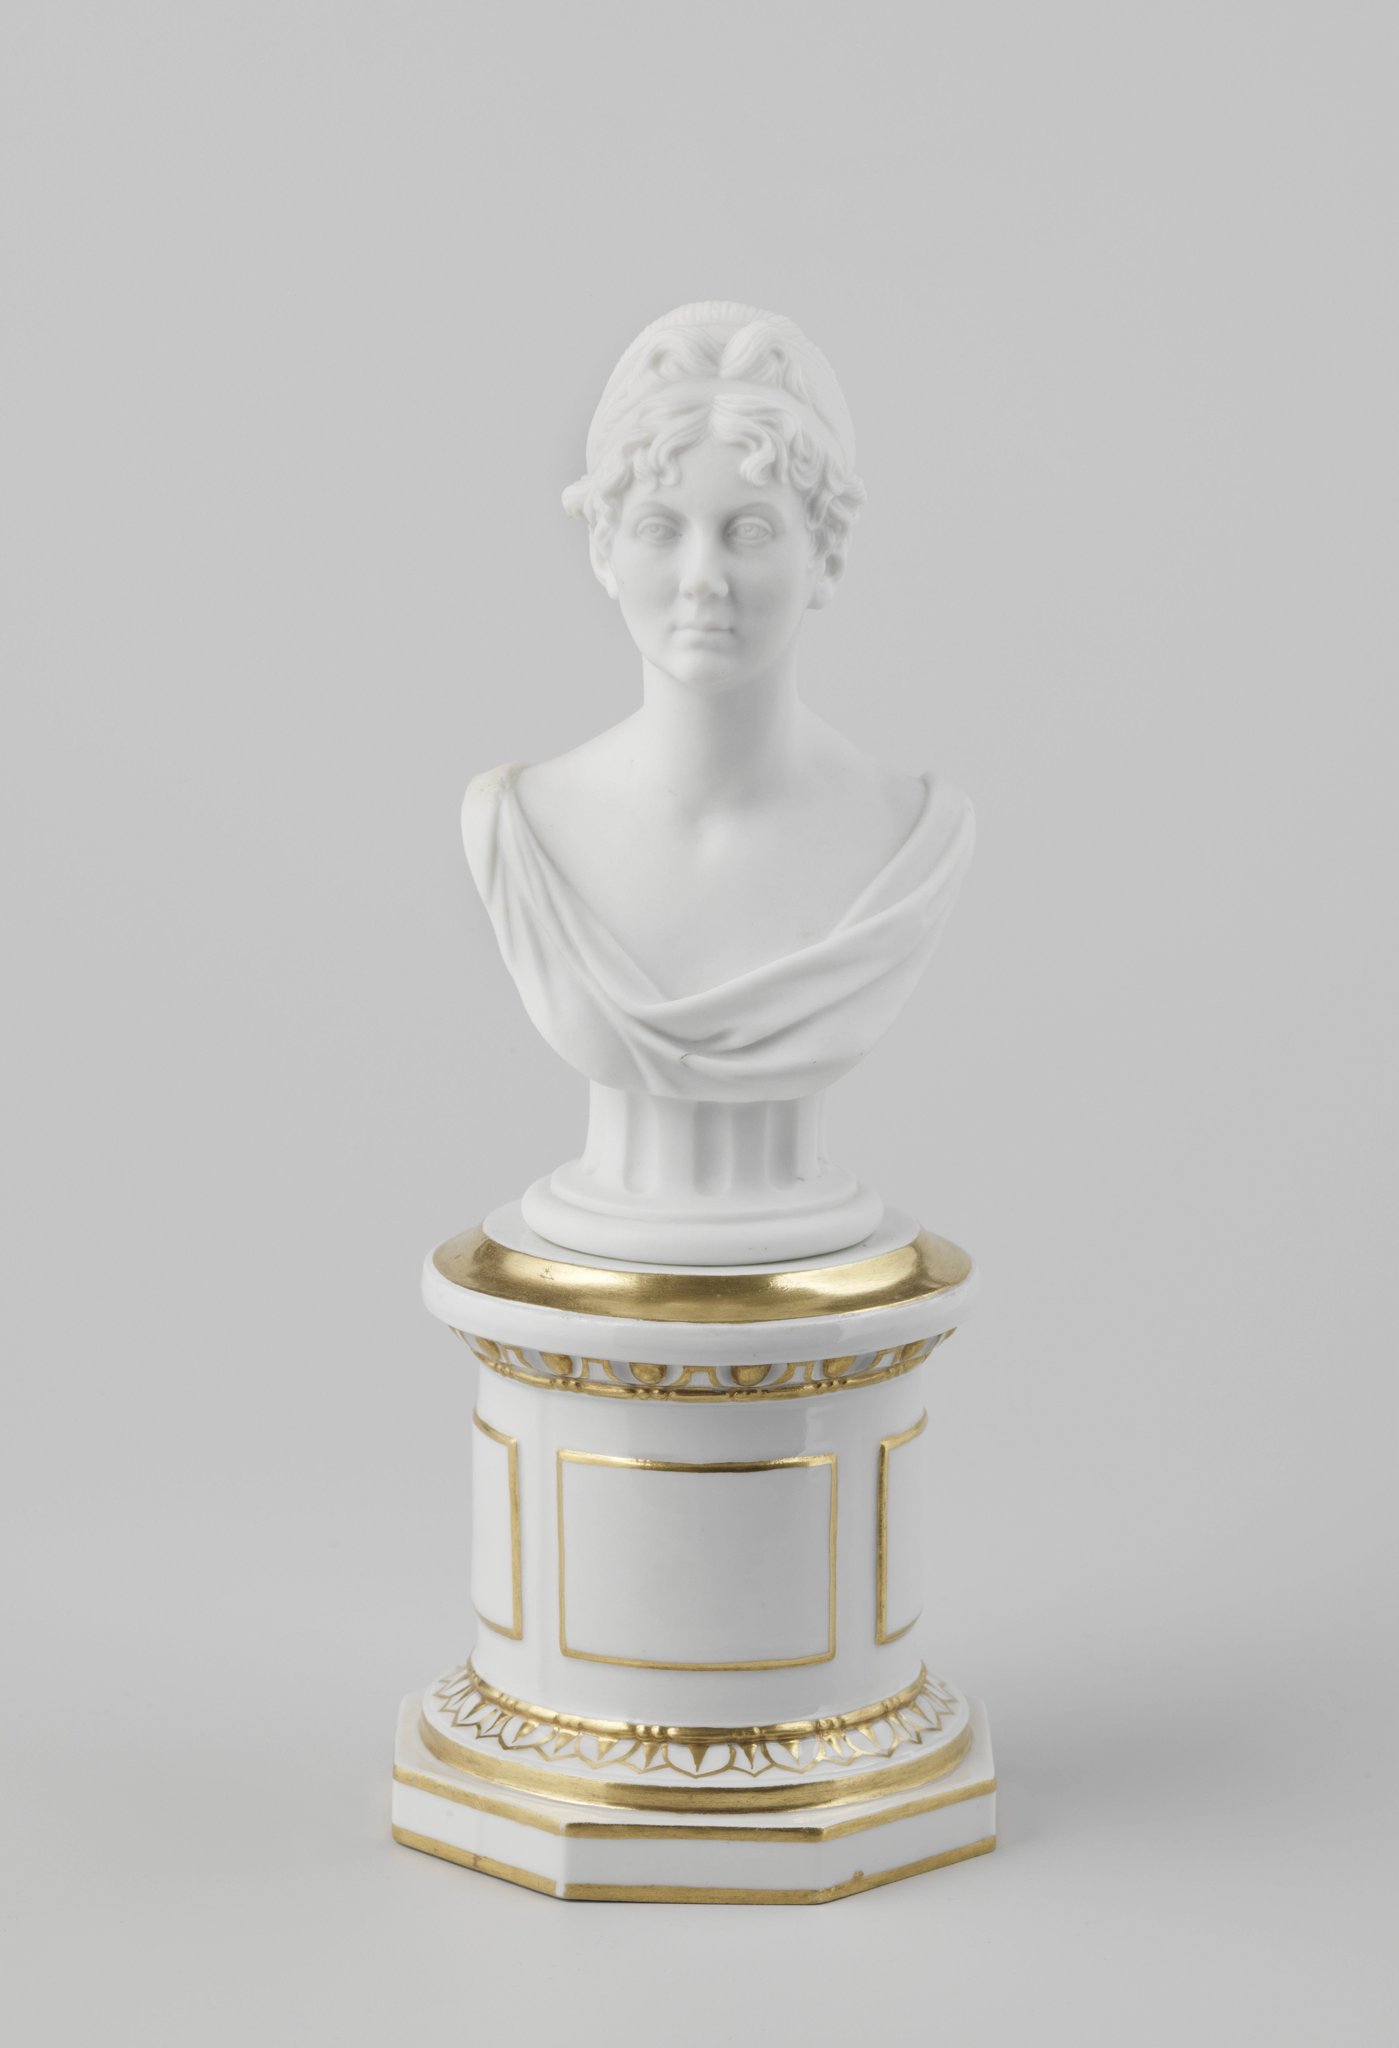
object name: bust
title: Bust of Frederika Louise Wilhelmina, princess of Prussia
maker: heinrich schwarzkopf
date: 1807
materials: glaze, gold, paint, porcelain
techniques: firing, forming, gilding, relief, vitrification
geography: furstenberg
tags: the hague, amsterdam, louise (prinses van oranje-nassau), historical persons - bb - woman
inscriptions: mark: ‘II.’, mark: ‘F 2’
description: Bust on base of Princess Wilhelmina of Prussia (1774 - 1837), wife of Prince William of Orange-Nassau (later King William I). Biscuit porcelain, Fürstenberg, c. 1807, model attributed to Heinrich Schwarzkopf.